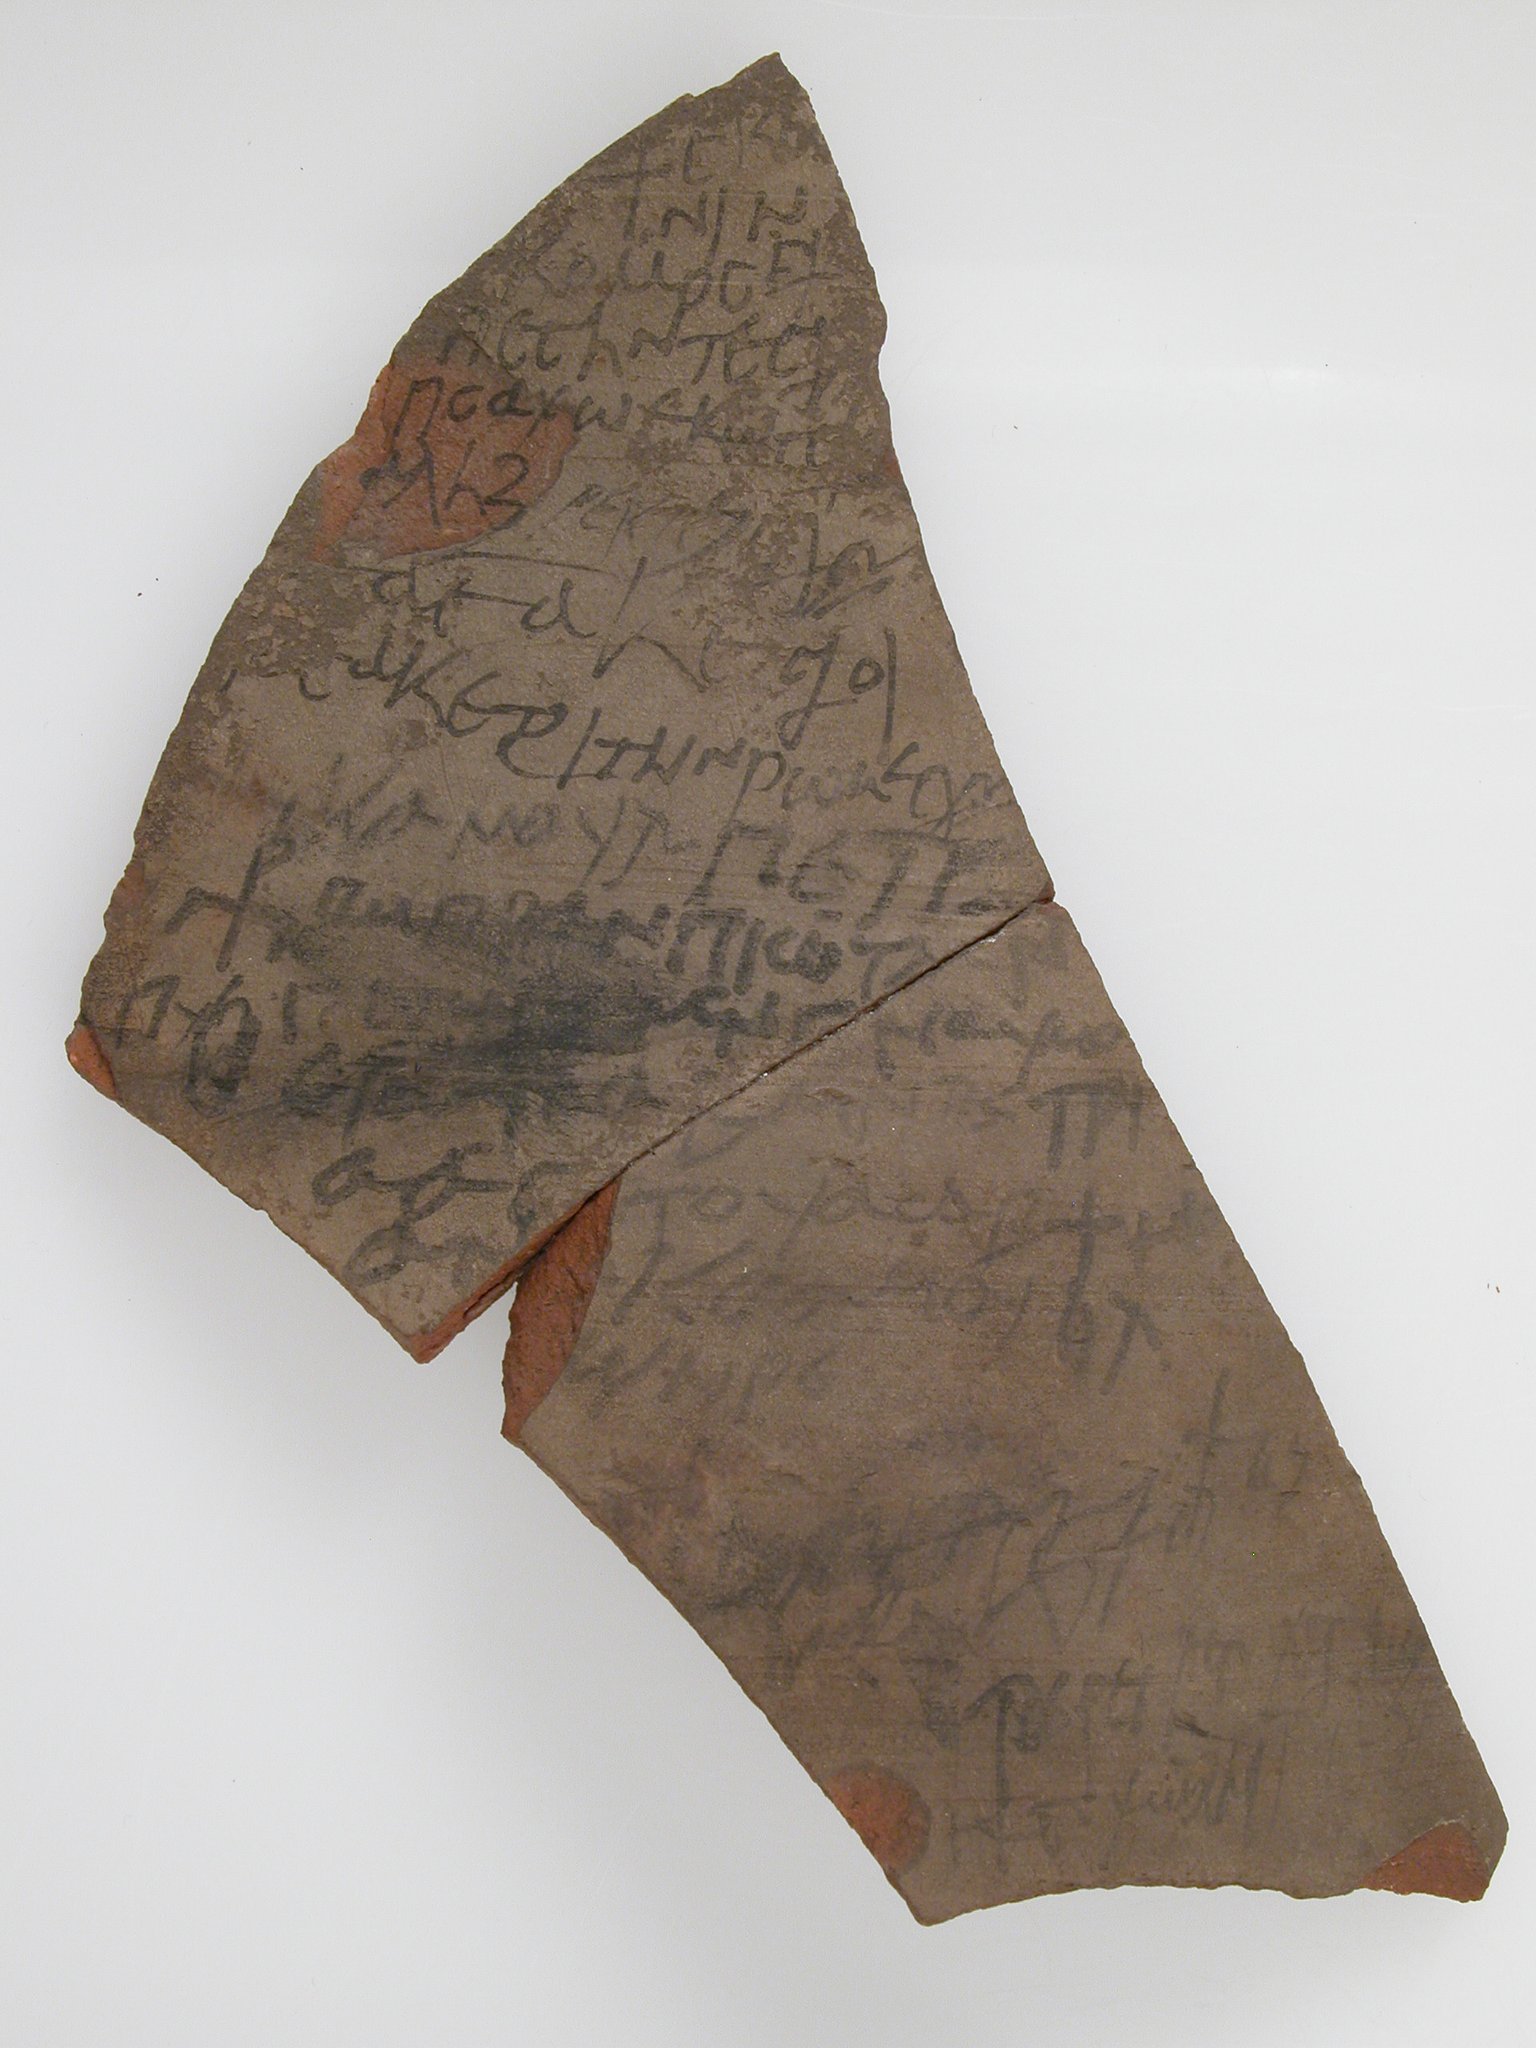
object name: ostrakon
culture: coptic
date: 601-700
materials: ink, pottery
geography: egypt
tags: documents